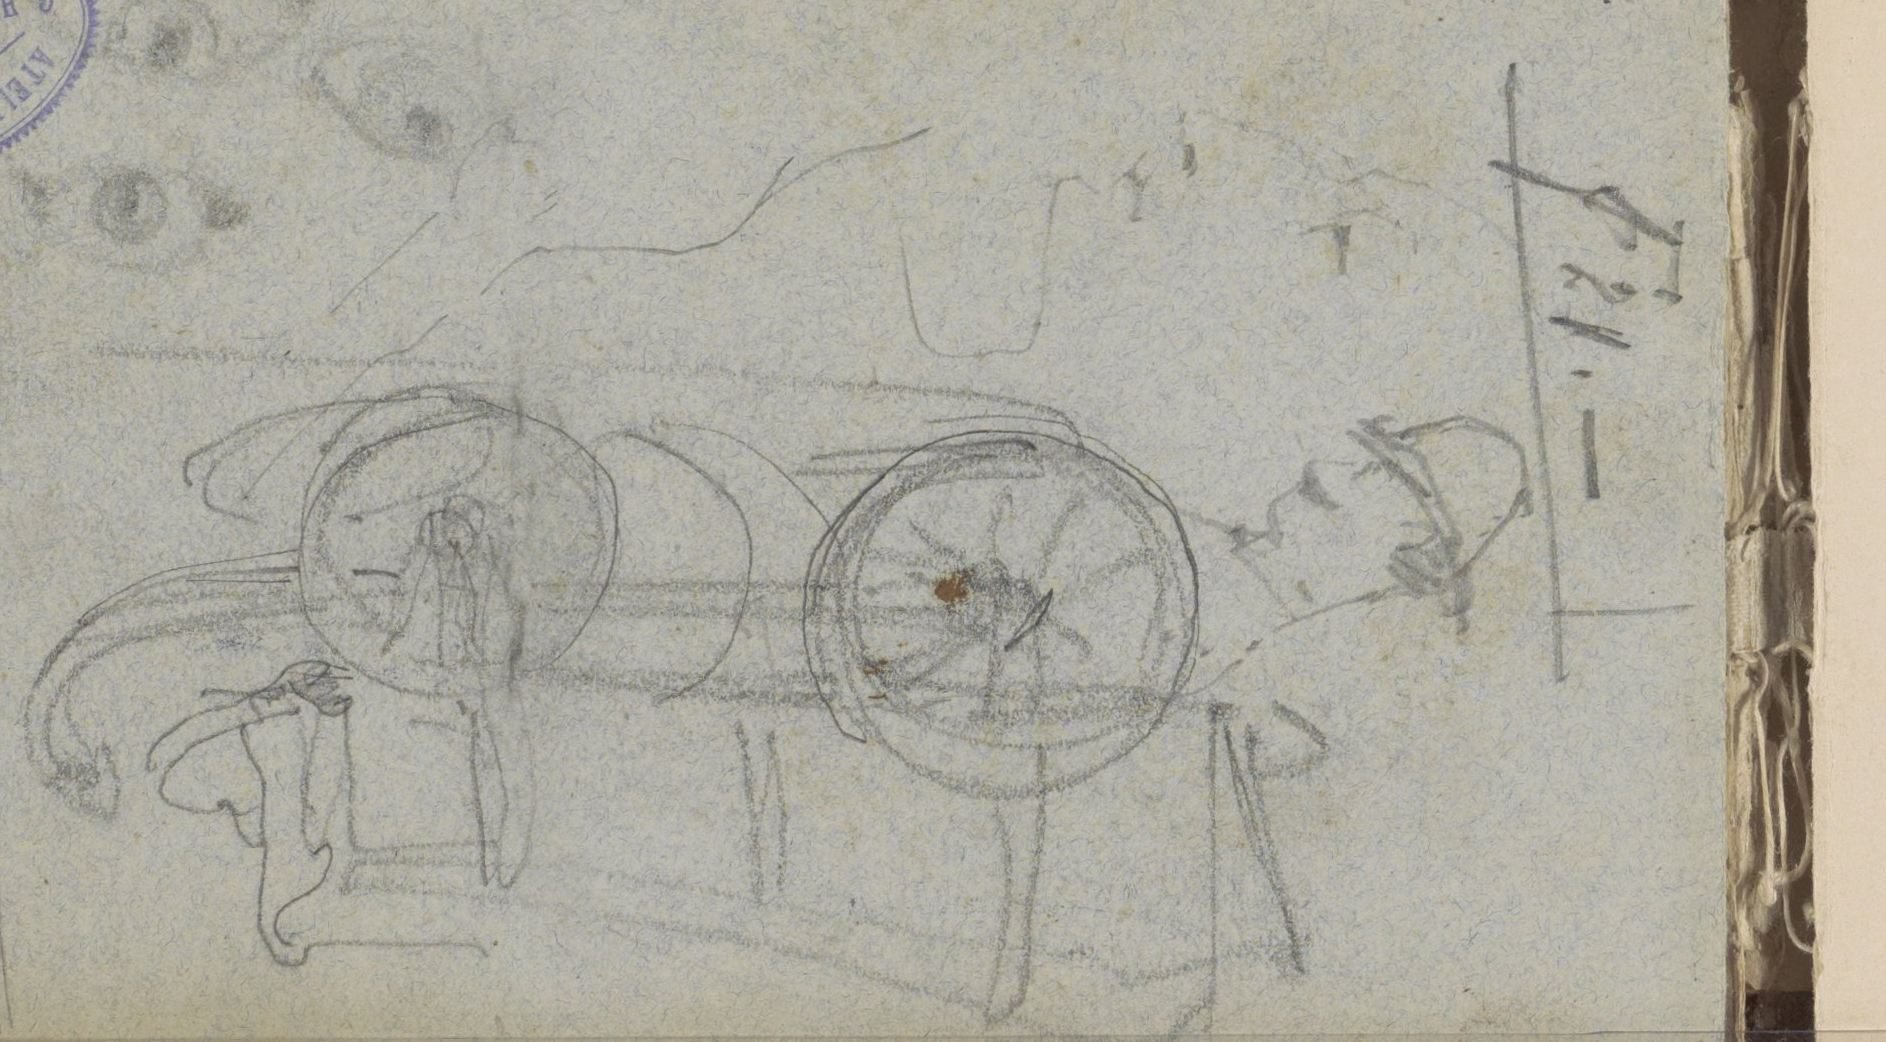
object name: endleaf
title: Figuurstudies en een wagen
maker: george hendrik breitner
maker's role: draughtsman, painter, print maker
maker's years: 1857-1923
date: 1880-1882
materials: paper, pencil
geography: the hague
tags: head (human), adult man, four-wheeled, animal-drawn vehicle, e.g.: cab, carriage, coach, eyes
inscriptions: annotation: ‘[...]’, workshop stamp: Lugt 291d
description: Schutblad B verso, vrij schutblad, uit een schetsboek met 16 bladen.